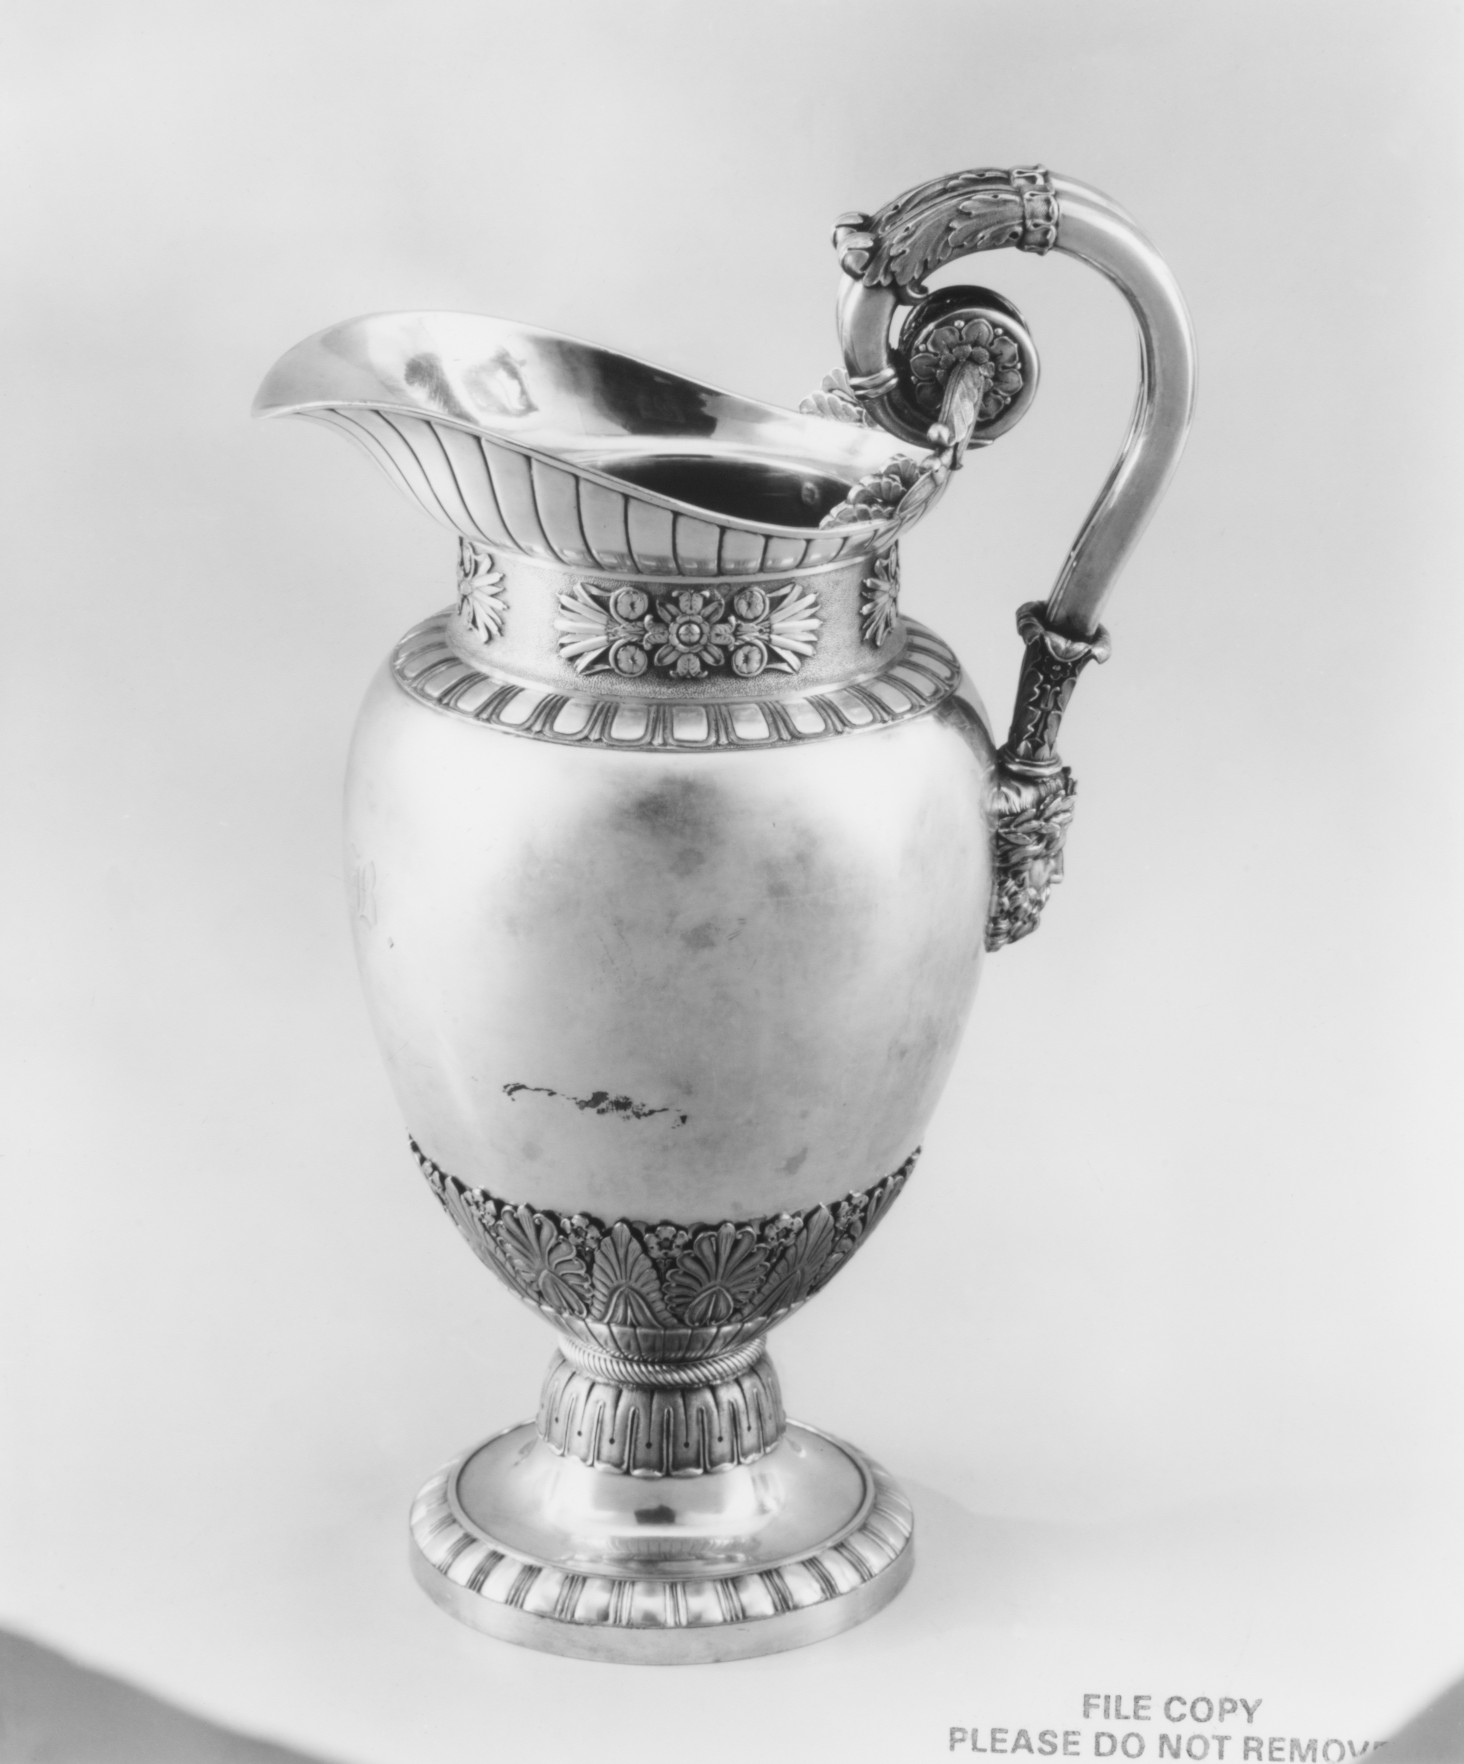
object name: ewer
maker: j.f.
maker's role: maker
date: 1793-1794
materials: silver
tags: flowers